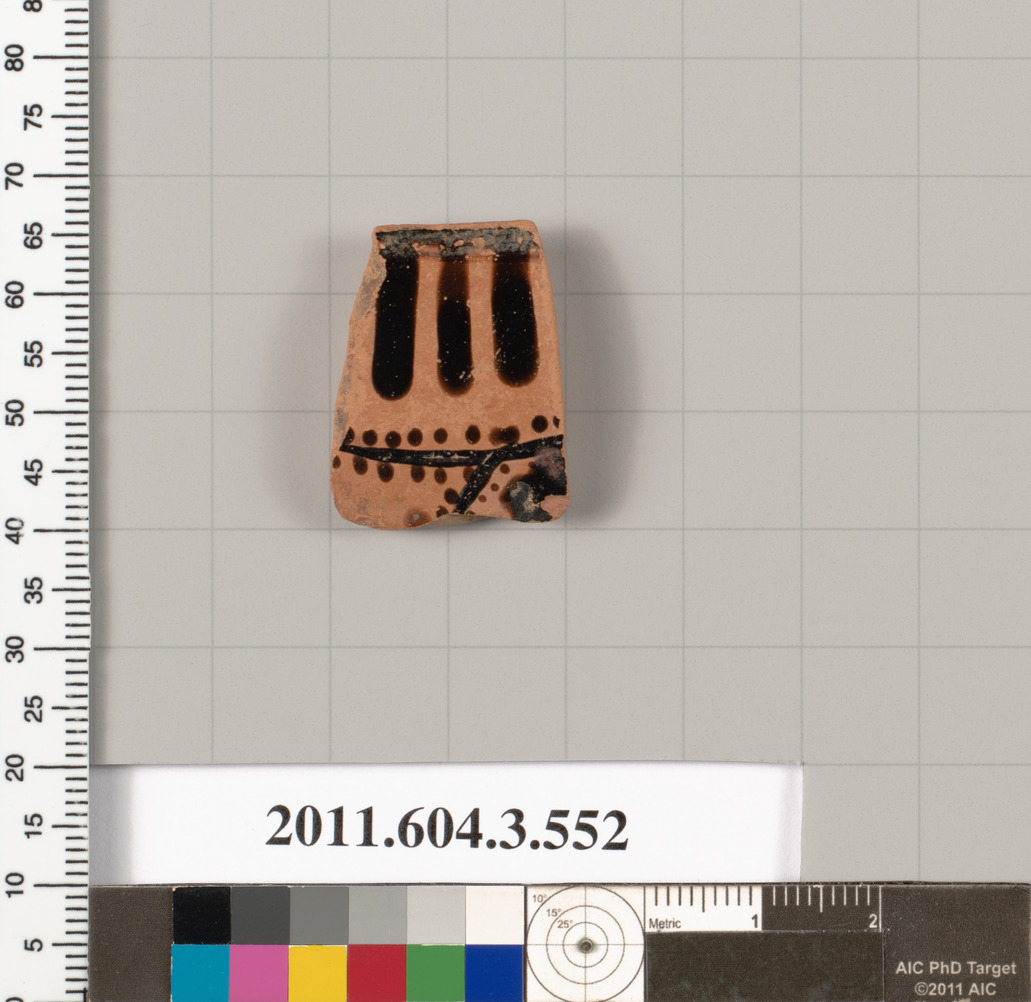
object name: column krater fragment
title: Terracotta fragment of a column-krater (bowl for mixing wine and water)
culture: greek, attic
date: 534-501 BCE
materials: terracotta